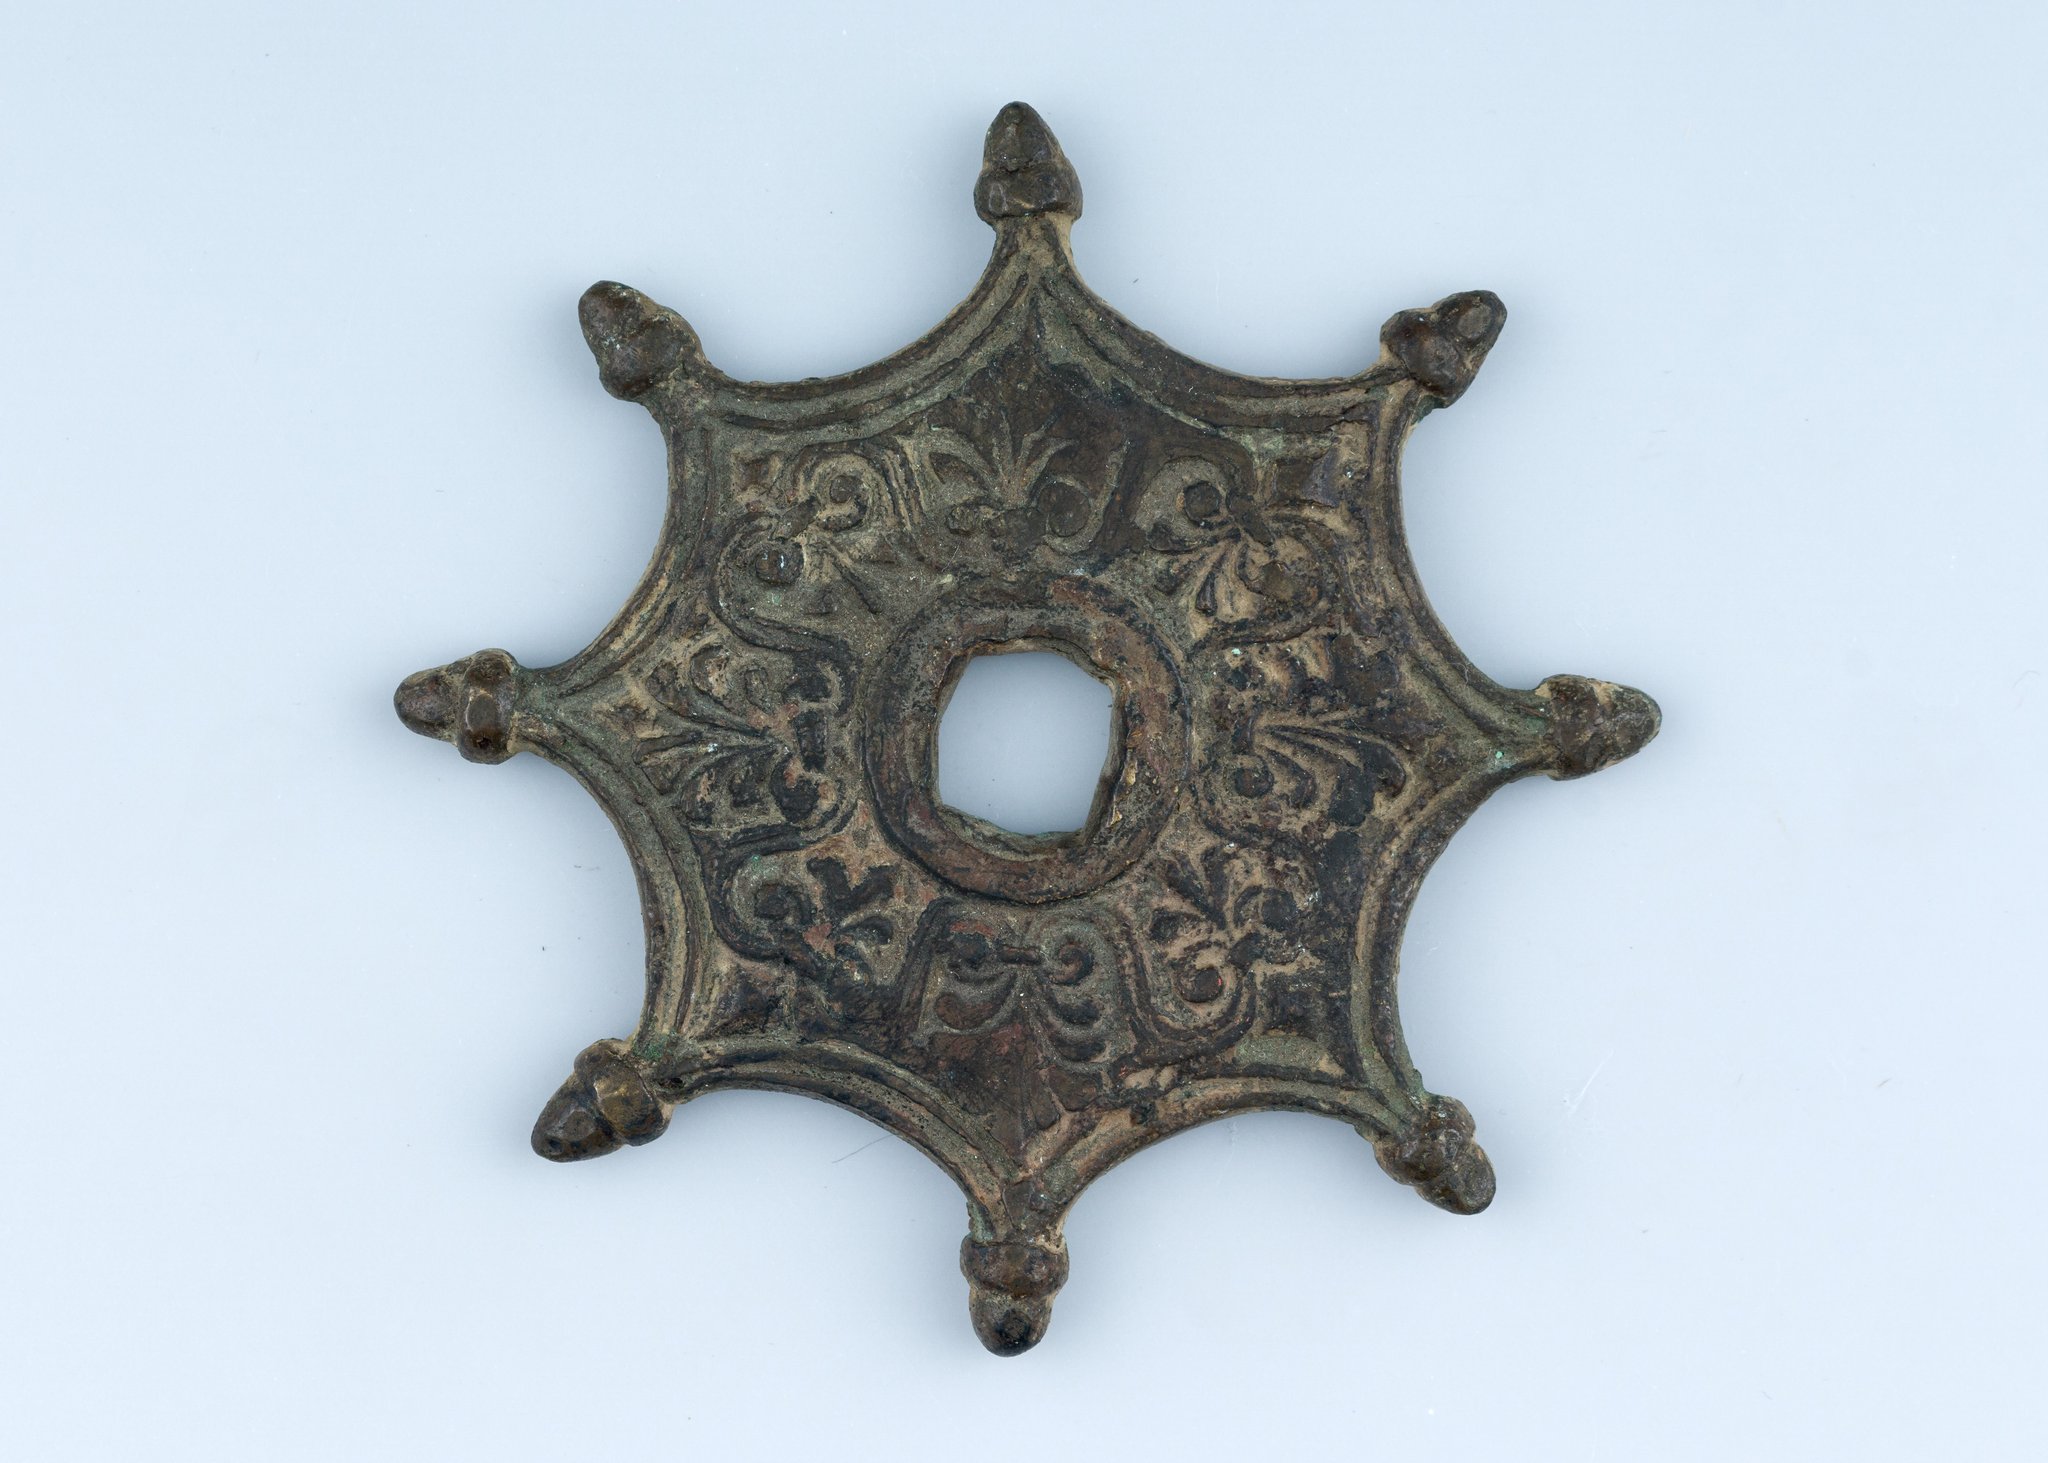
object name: washer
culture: european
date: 1401-1700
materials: bronze